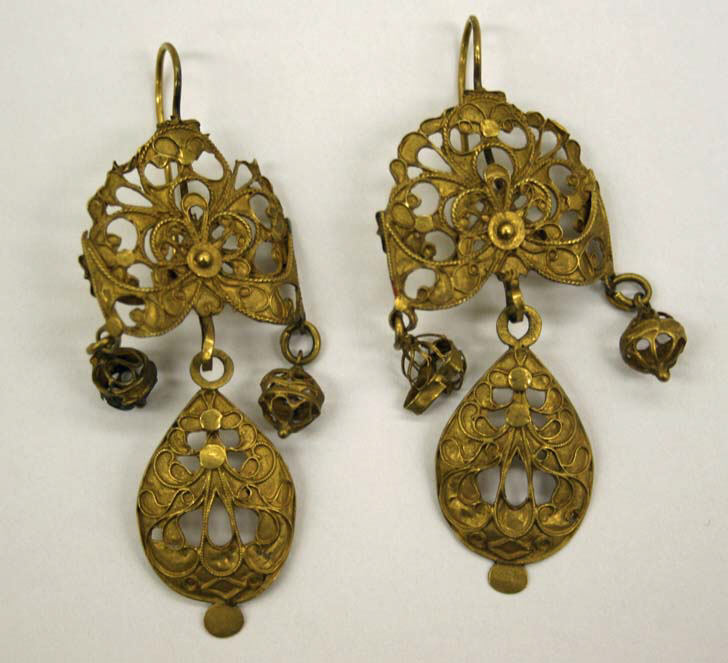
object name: earring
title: Earrings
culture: european, eastern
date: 1701-1900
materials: metal